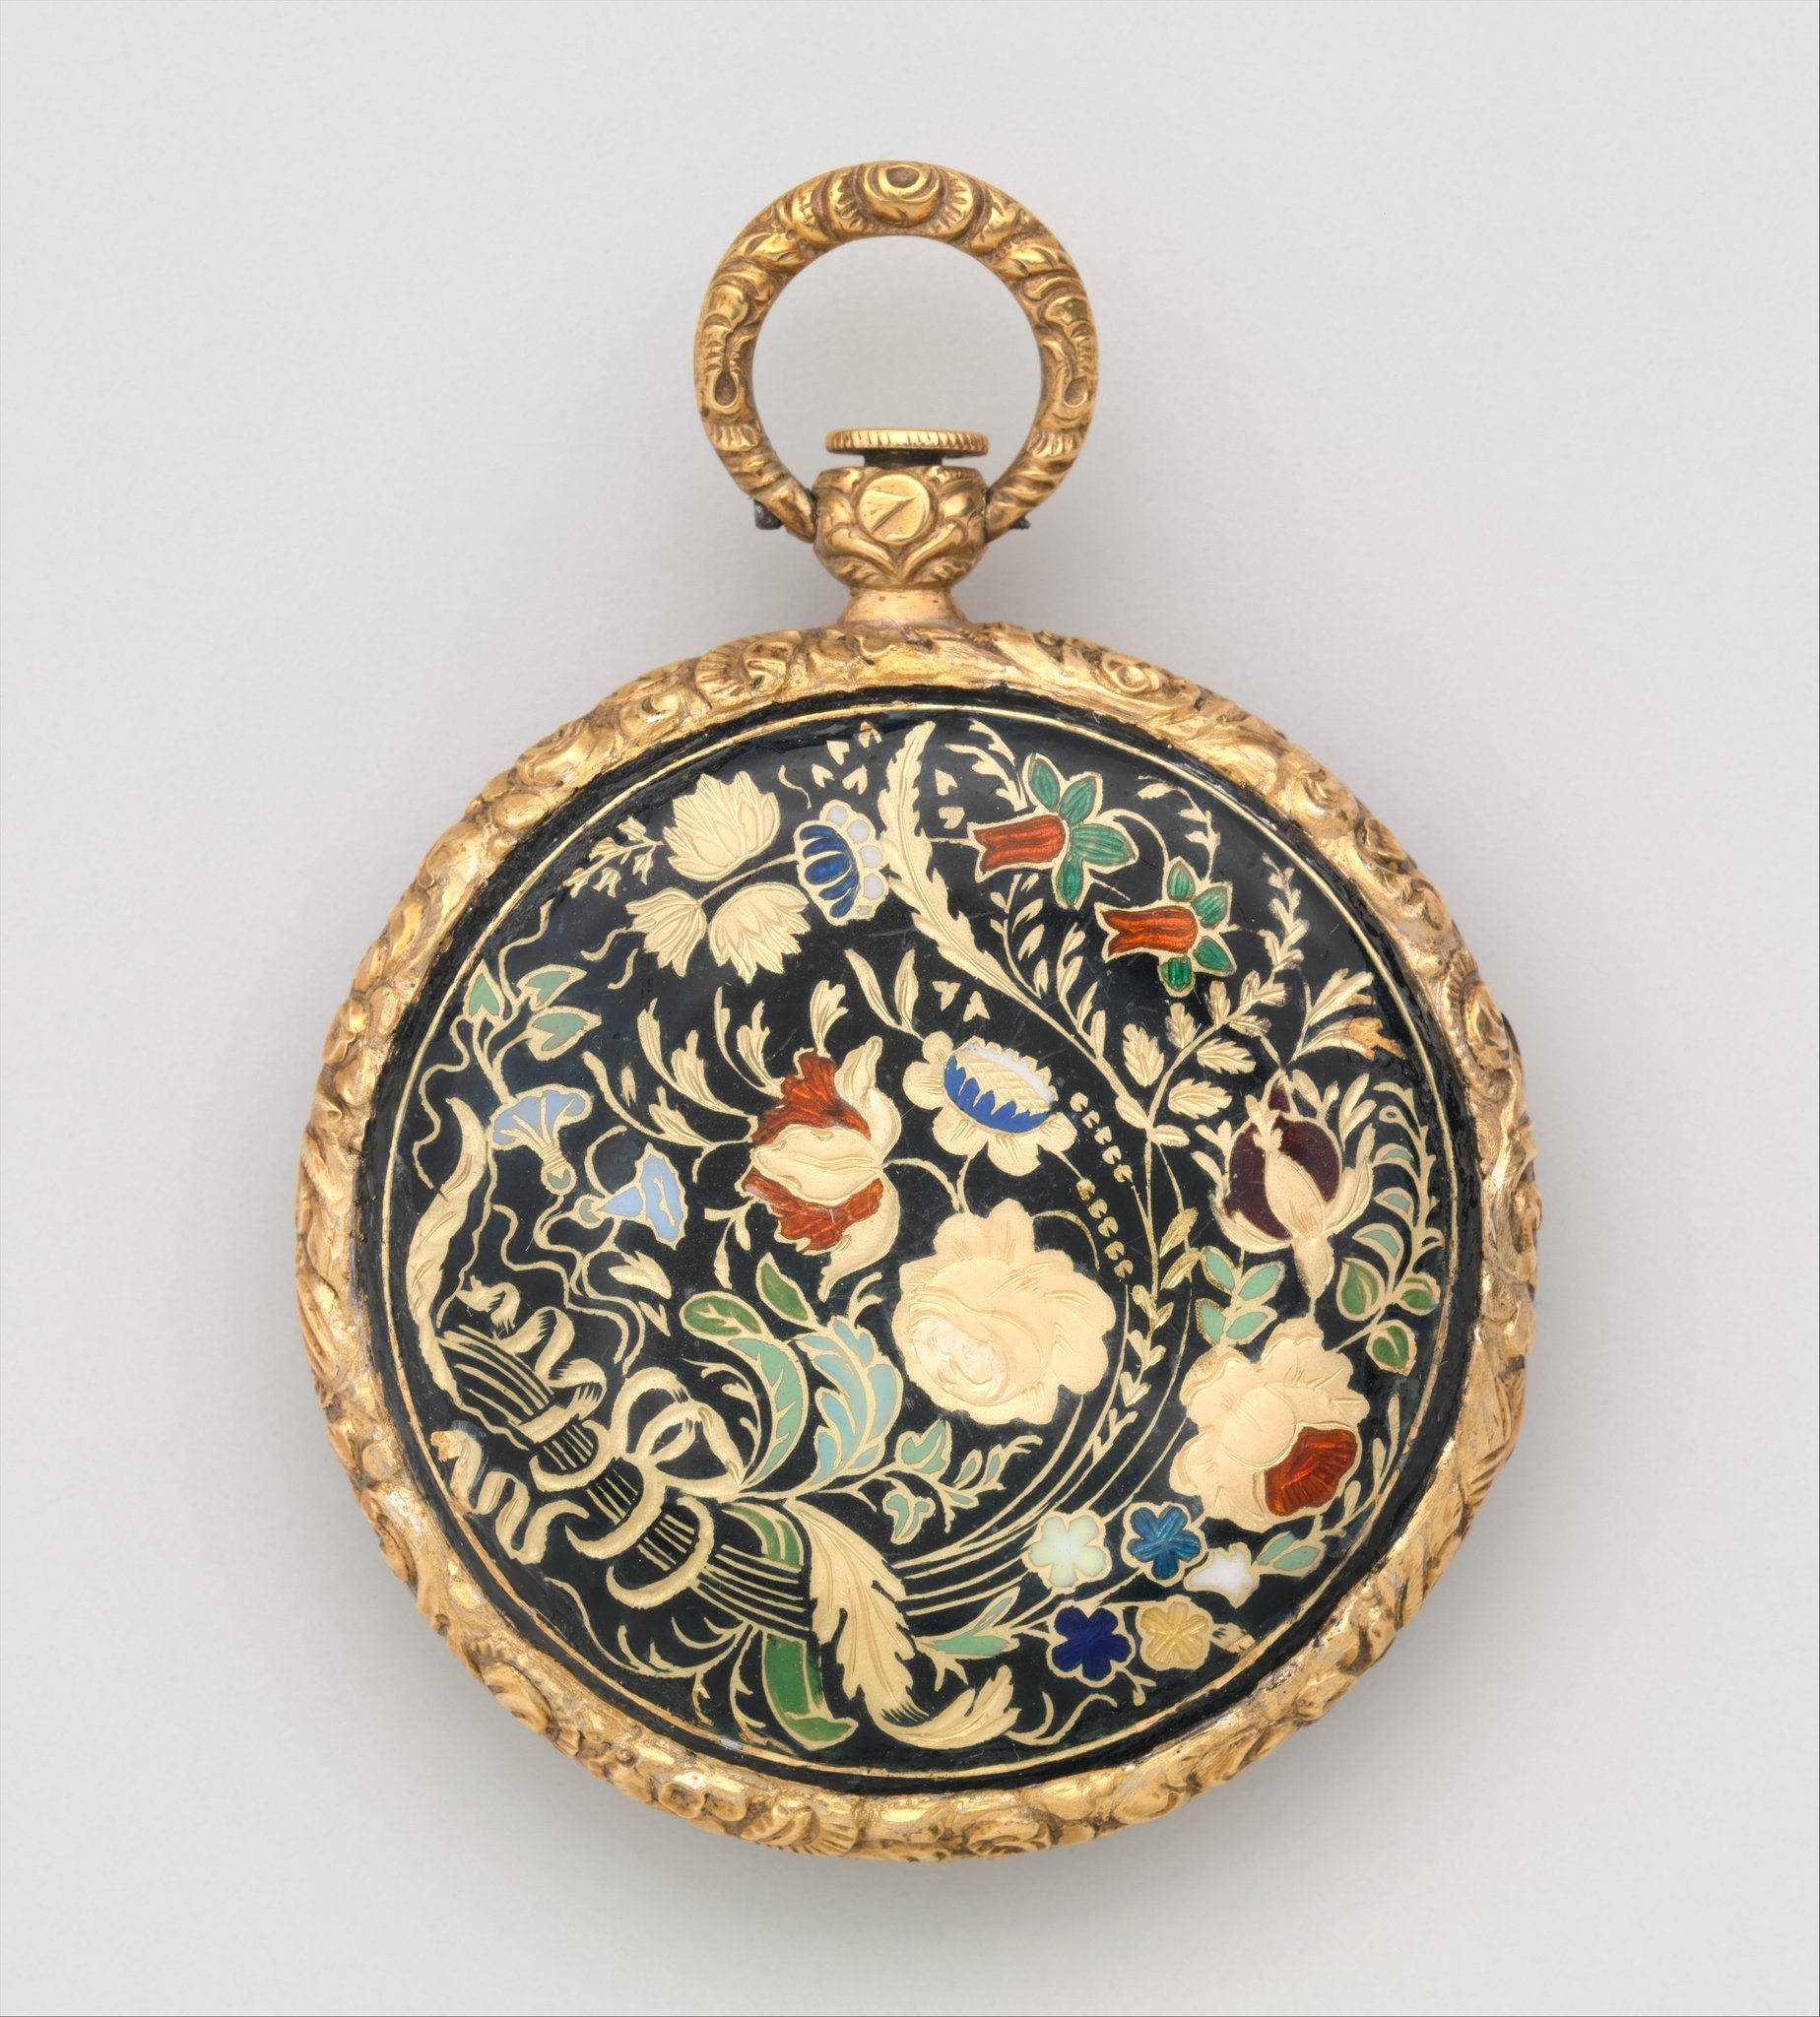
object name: watch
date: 1822-1838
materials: enamel, gold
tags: flowers,leaves